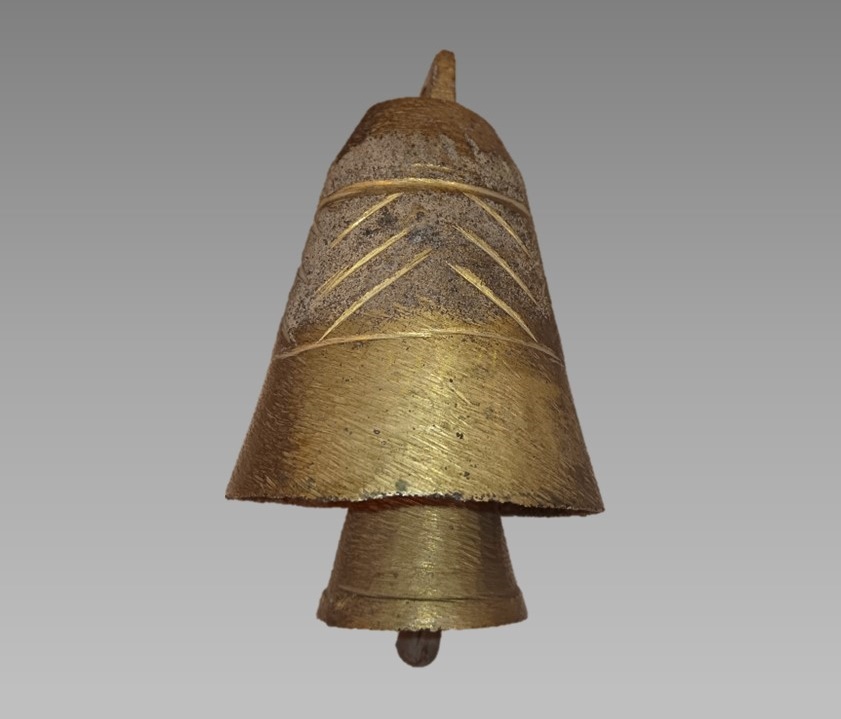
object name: zanguleh zangula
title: Zanguleh (zangula)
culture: iranian or persian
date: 1867-1900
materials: metal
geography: iran